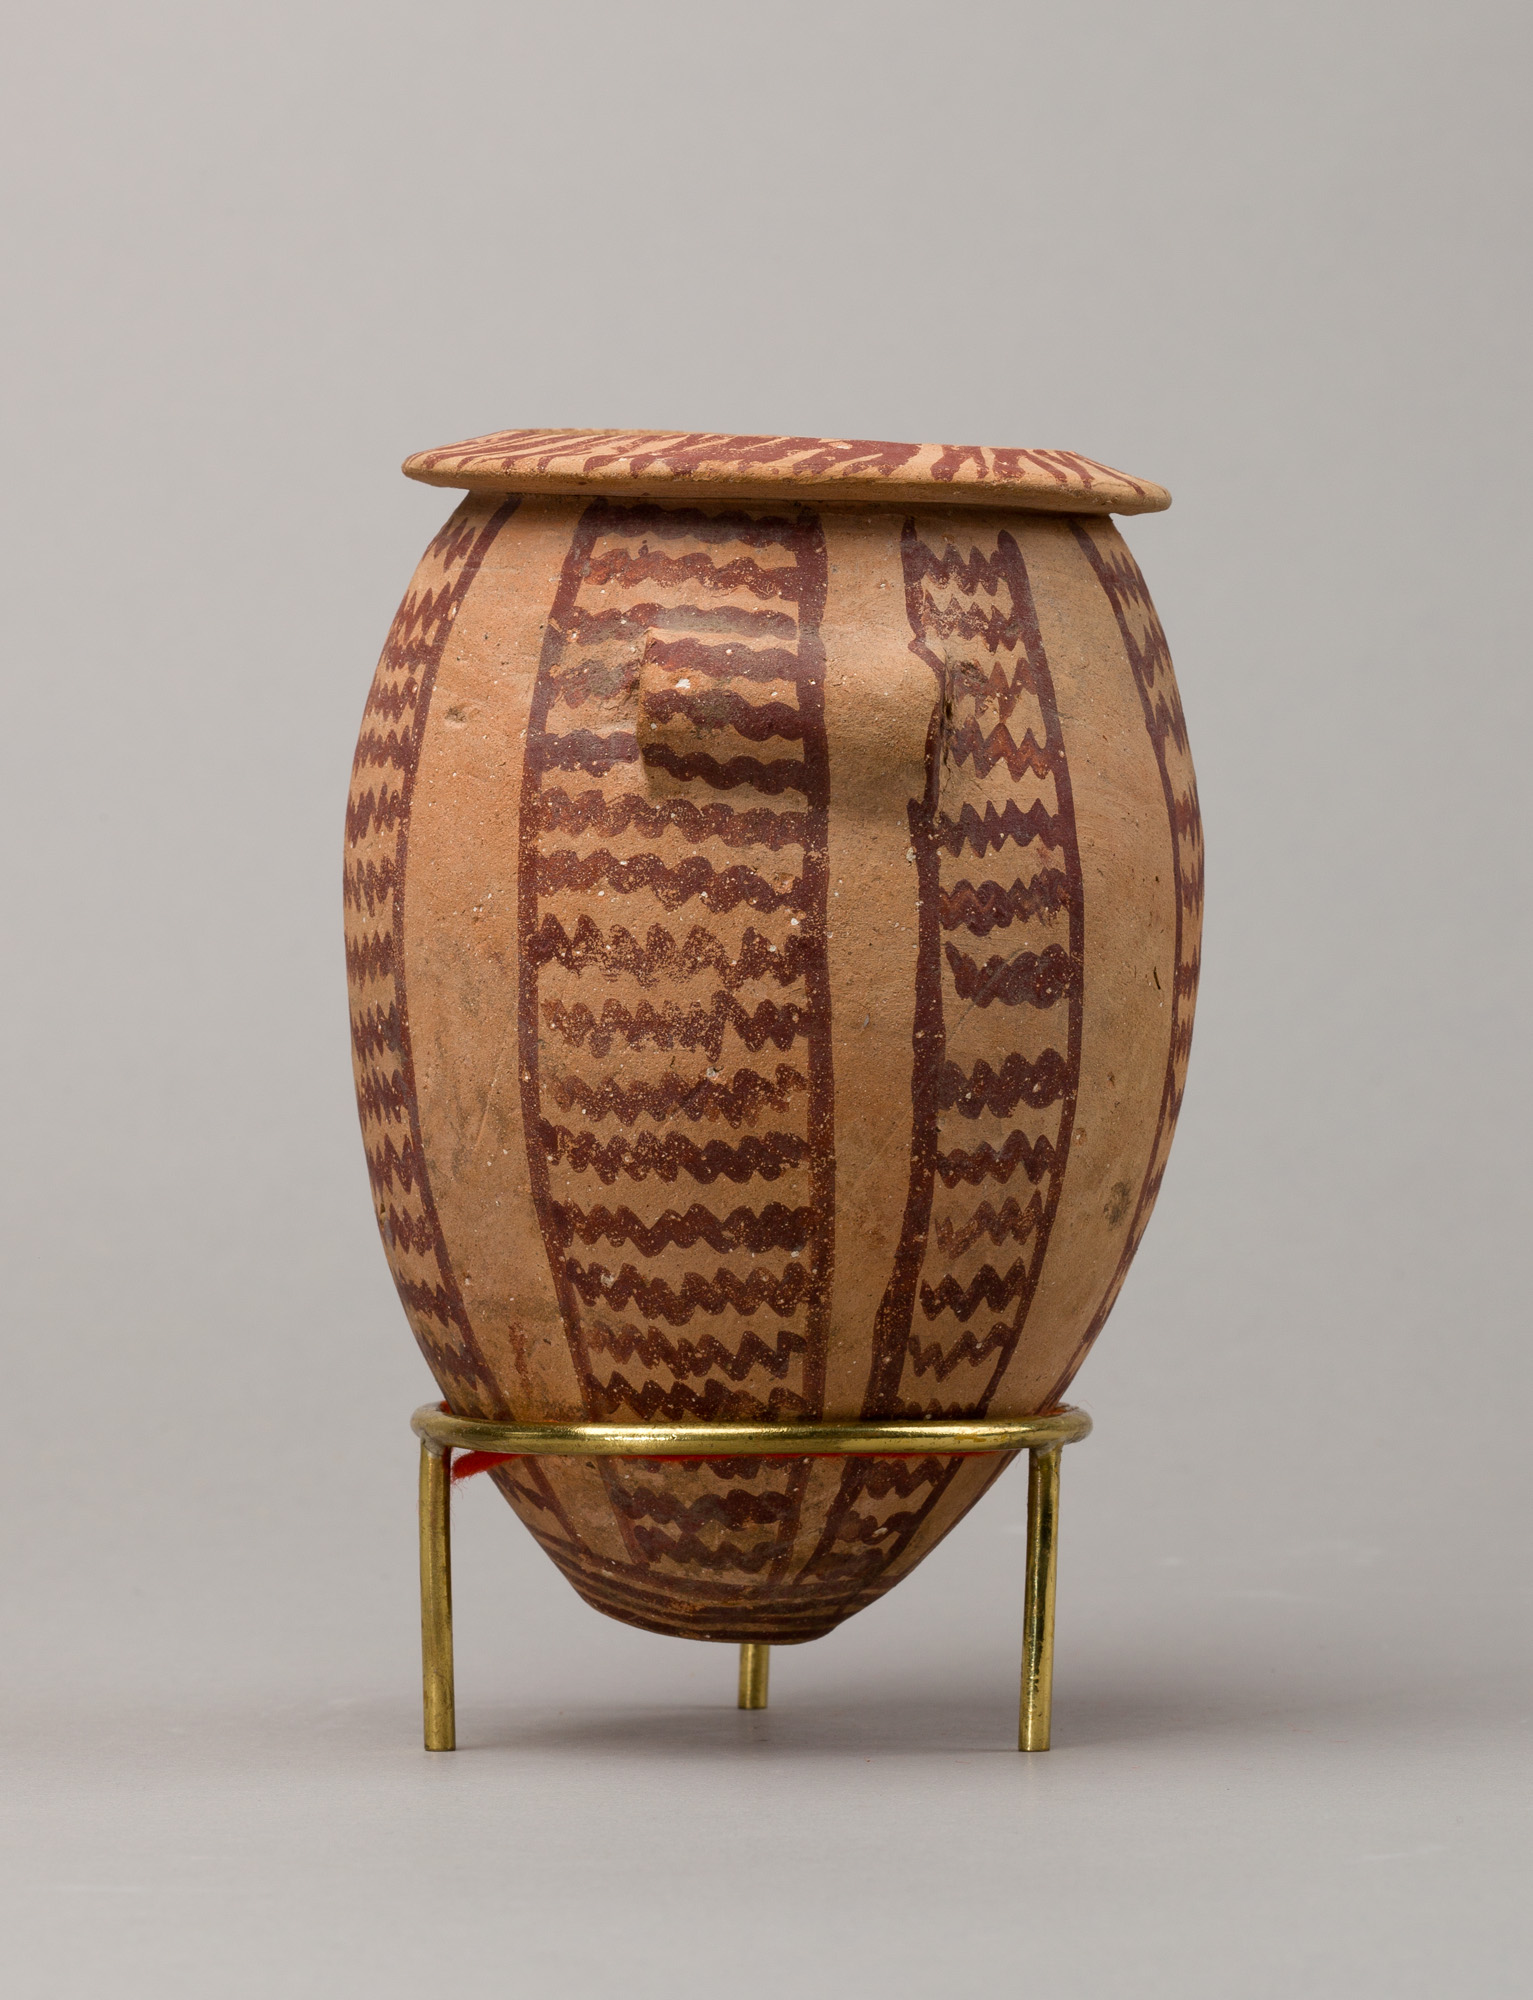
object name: jar, decorated ware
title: Decorated ware jar with lug handles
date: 3650-3300 BCE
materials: paint, pottery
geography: egypt